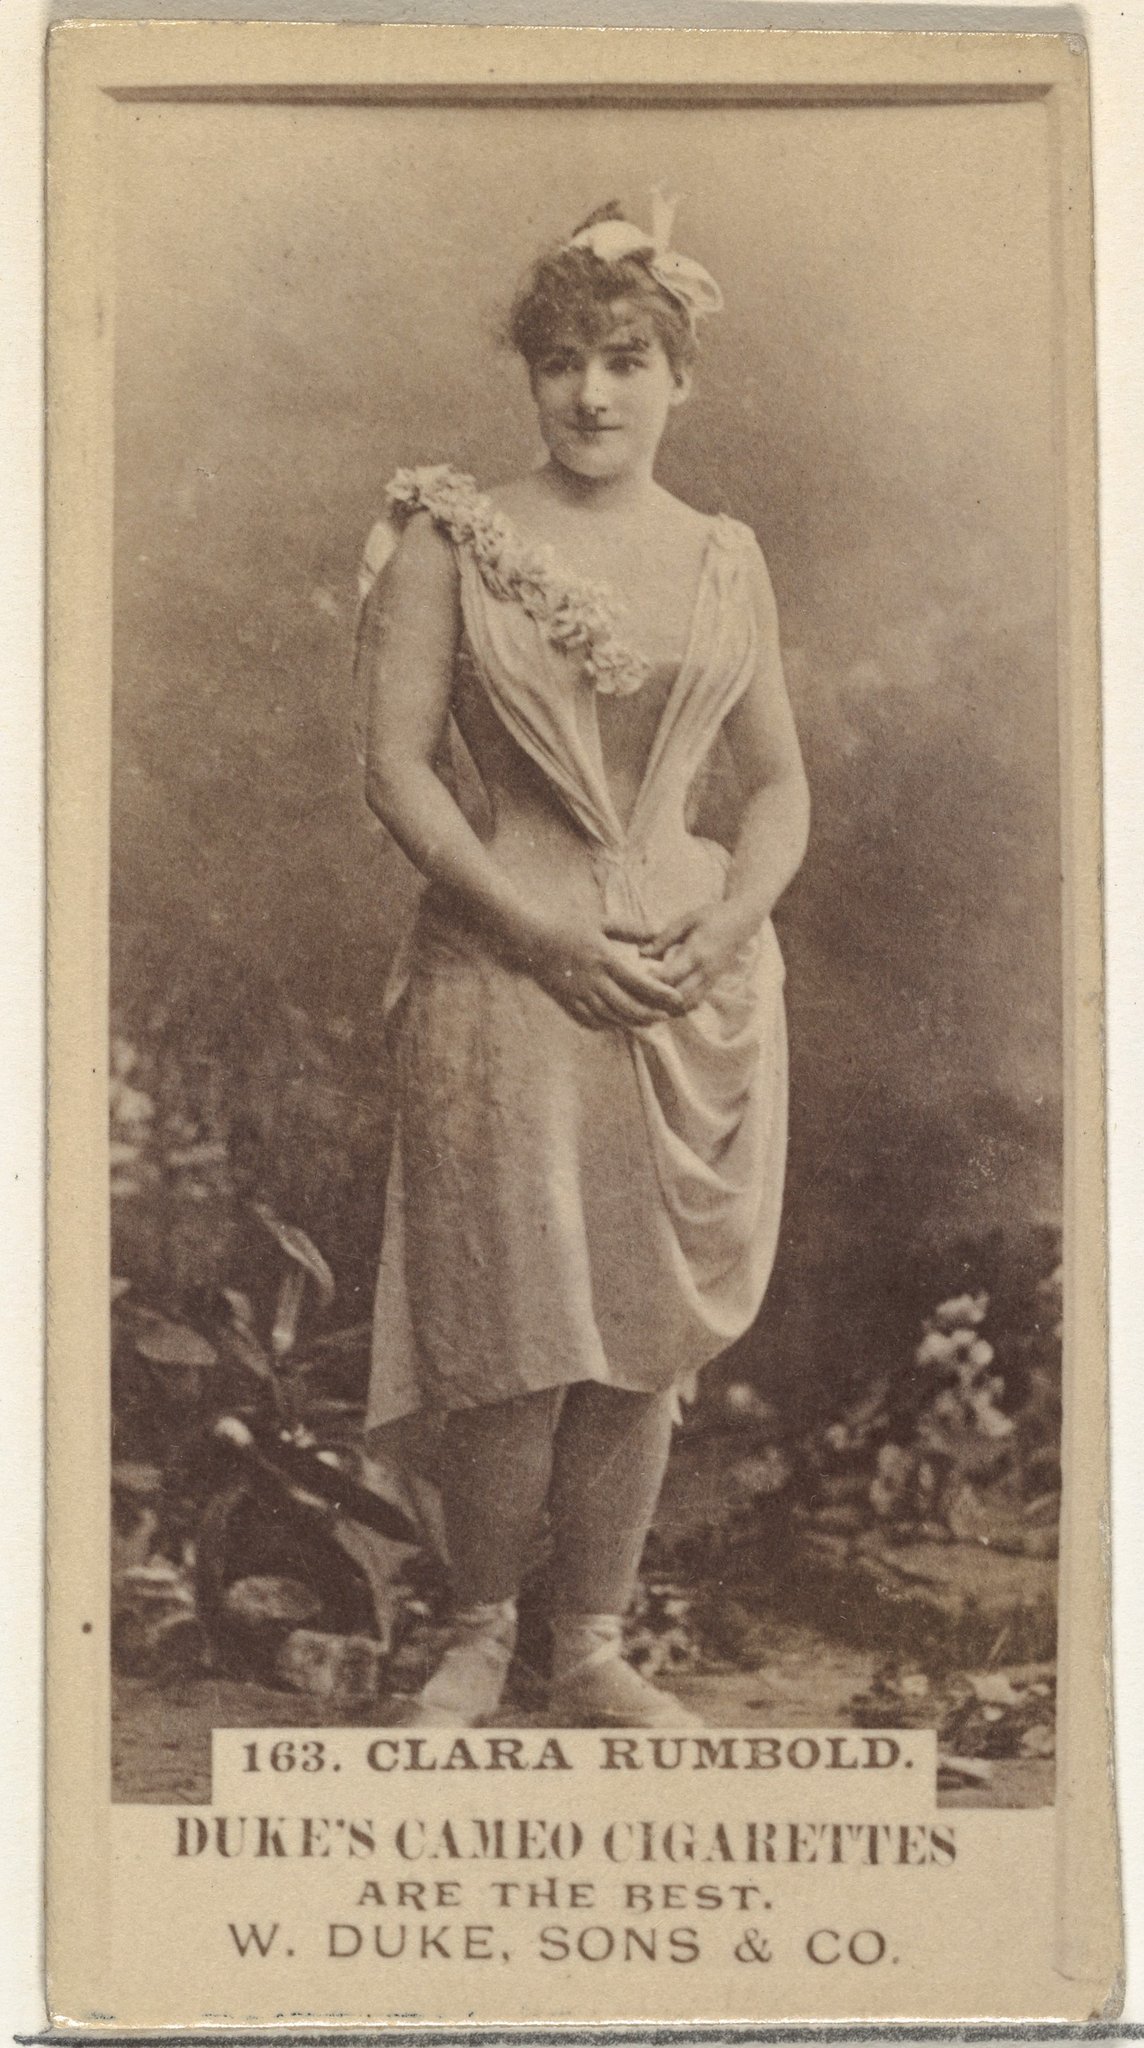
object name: photograph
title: Card Number 163, Carrie Rumbold, from the Actors and Actresses series (N145-5) issued by Duke Sons & Co. to promote Cameo Cigarettes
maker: w. duke, sons & co.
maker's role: publisher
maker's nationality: american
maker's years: 1870-1920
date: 1880-1889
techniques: albumen silver print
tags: portraits,women,actresses